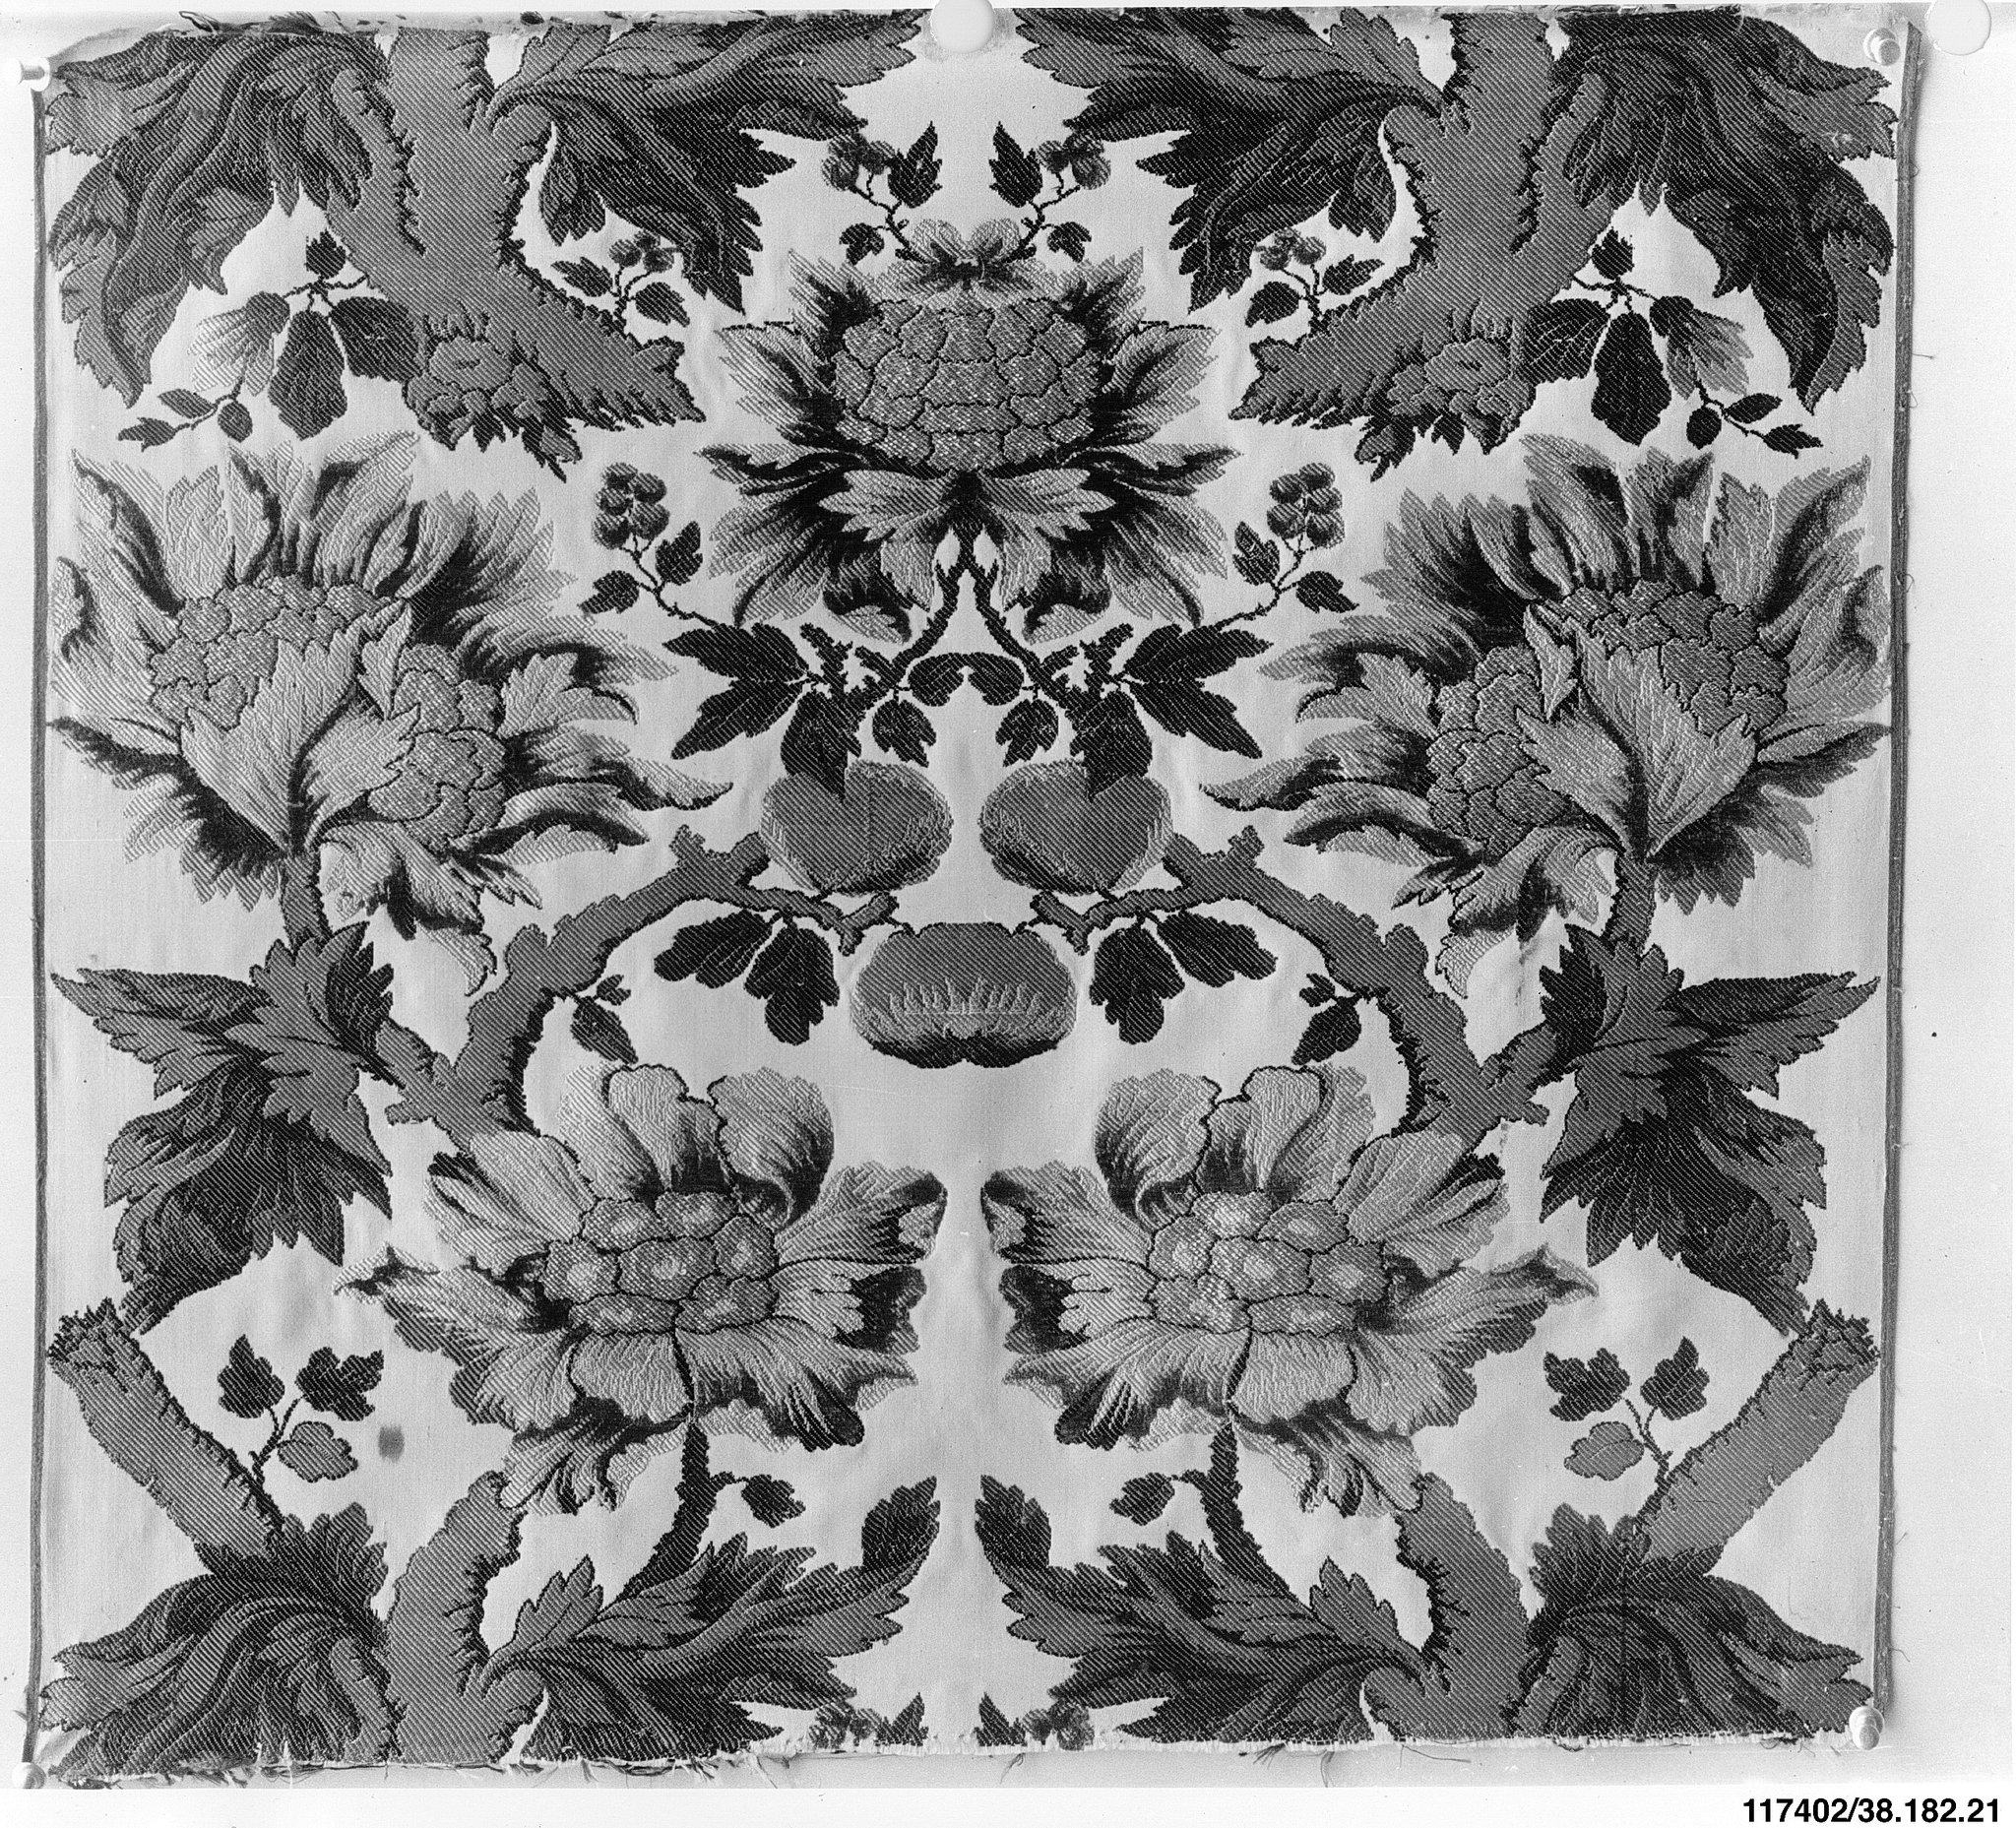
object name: piece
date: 1733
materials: silk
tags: flowers